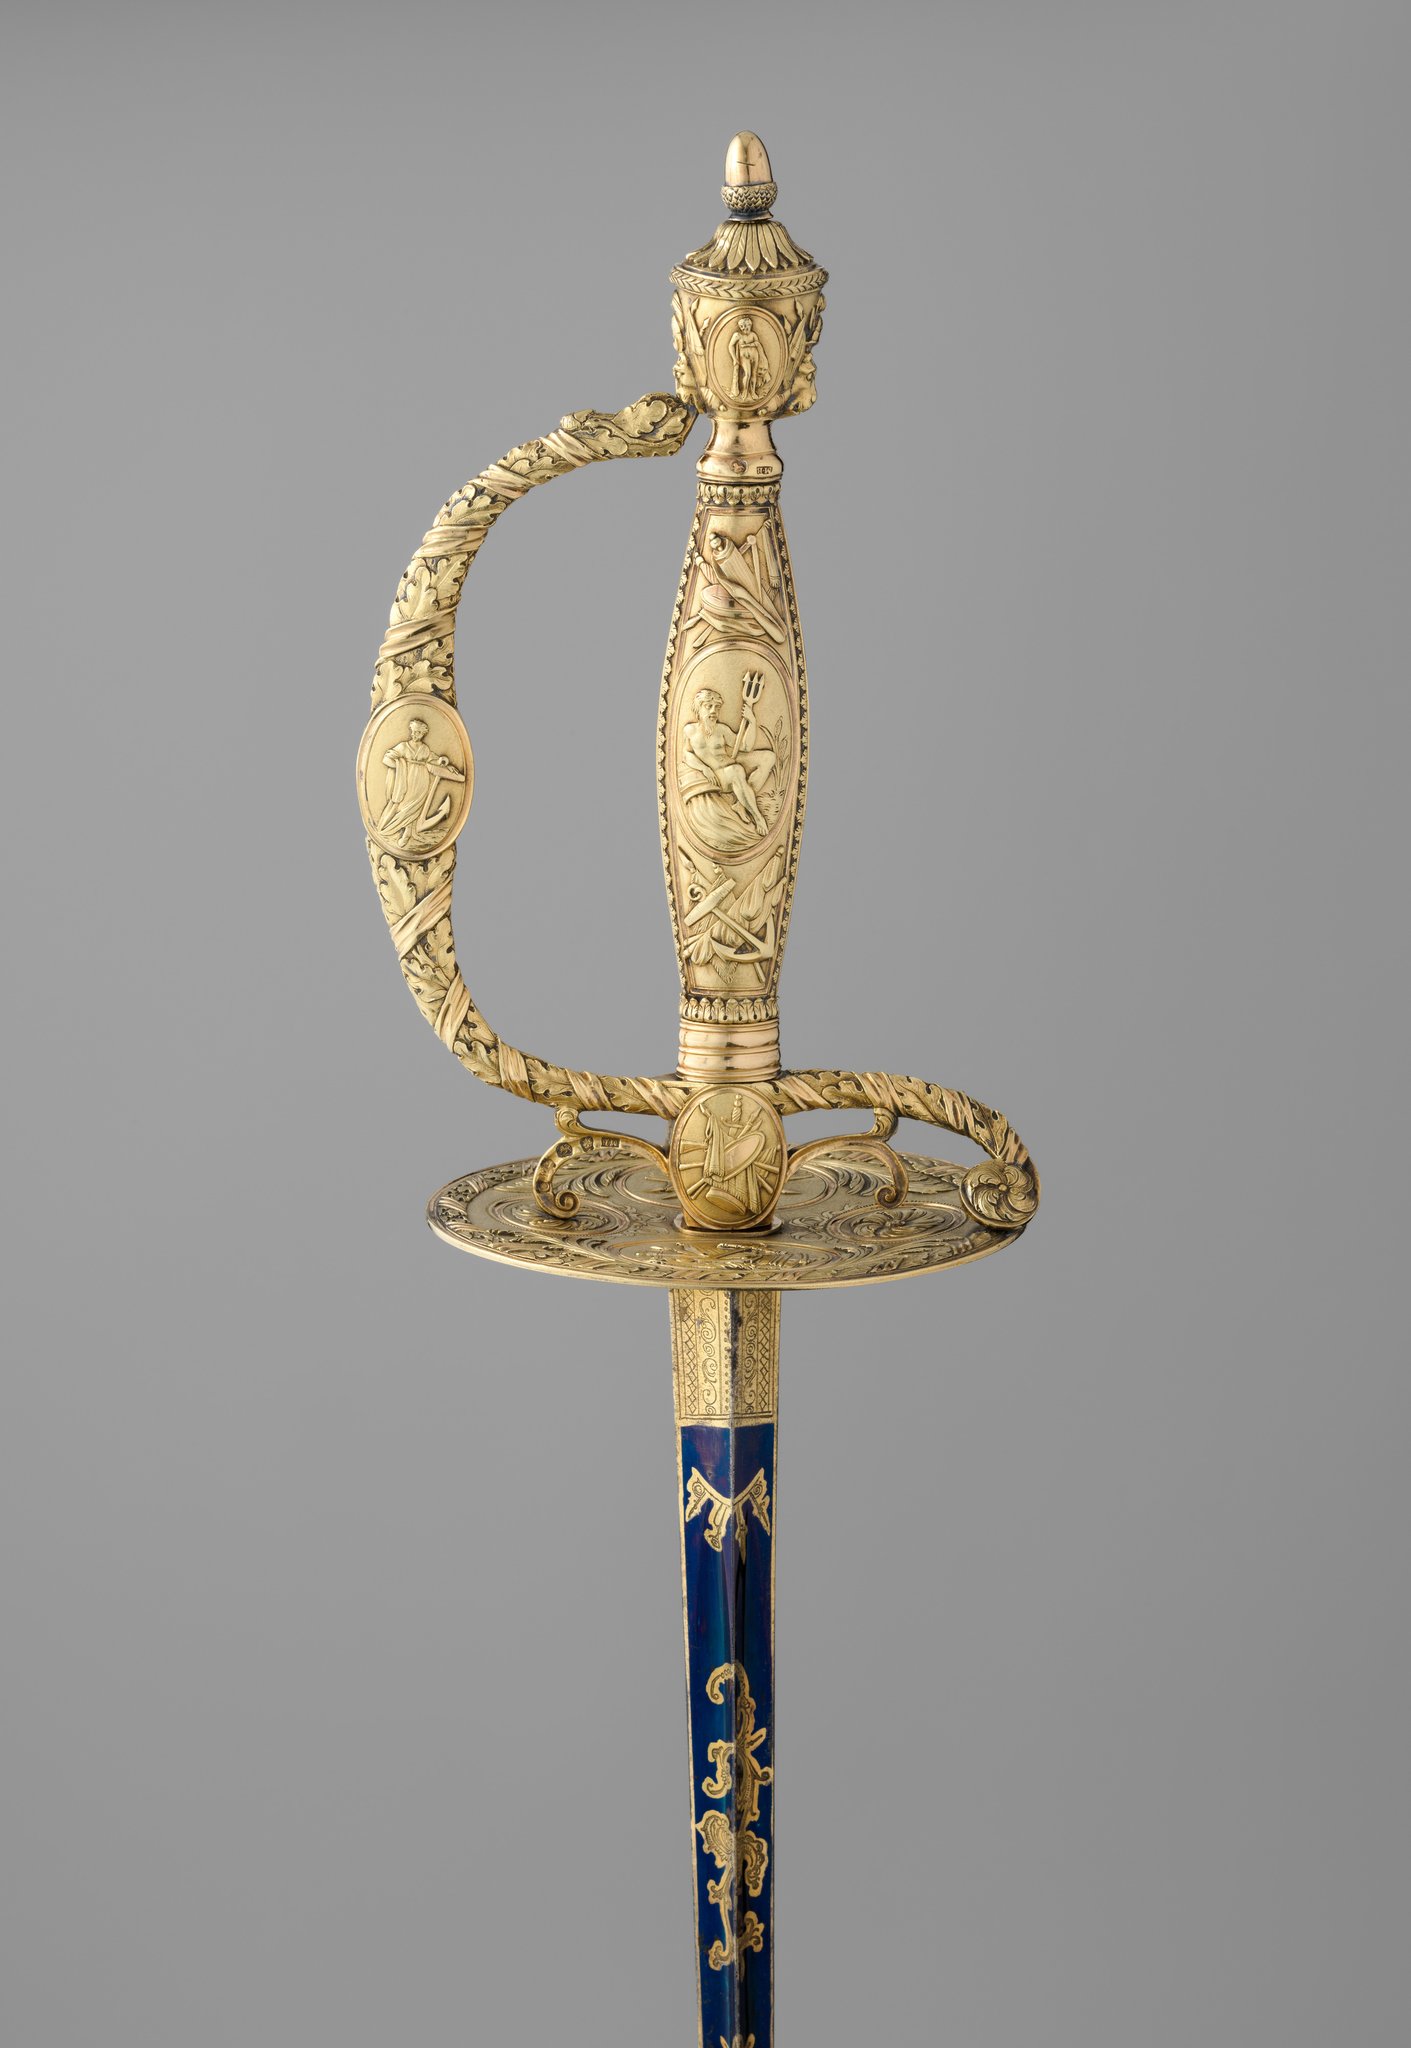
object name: smallsword with scabbard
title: Smallsword with Scabbard and Case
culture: british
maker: michael barnett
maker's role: silversmith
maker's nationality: british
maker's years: 1758-1850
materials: copper alloy, felt, gold, leather, silk, silver, steel, parchment, wood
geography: england